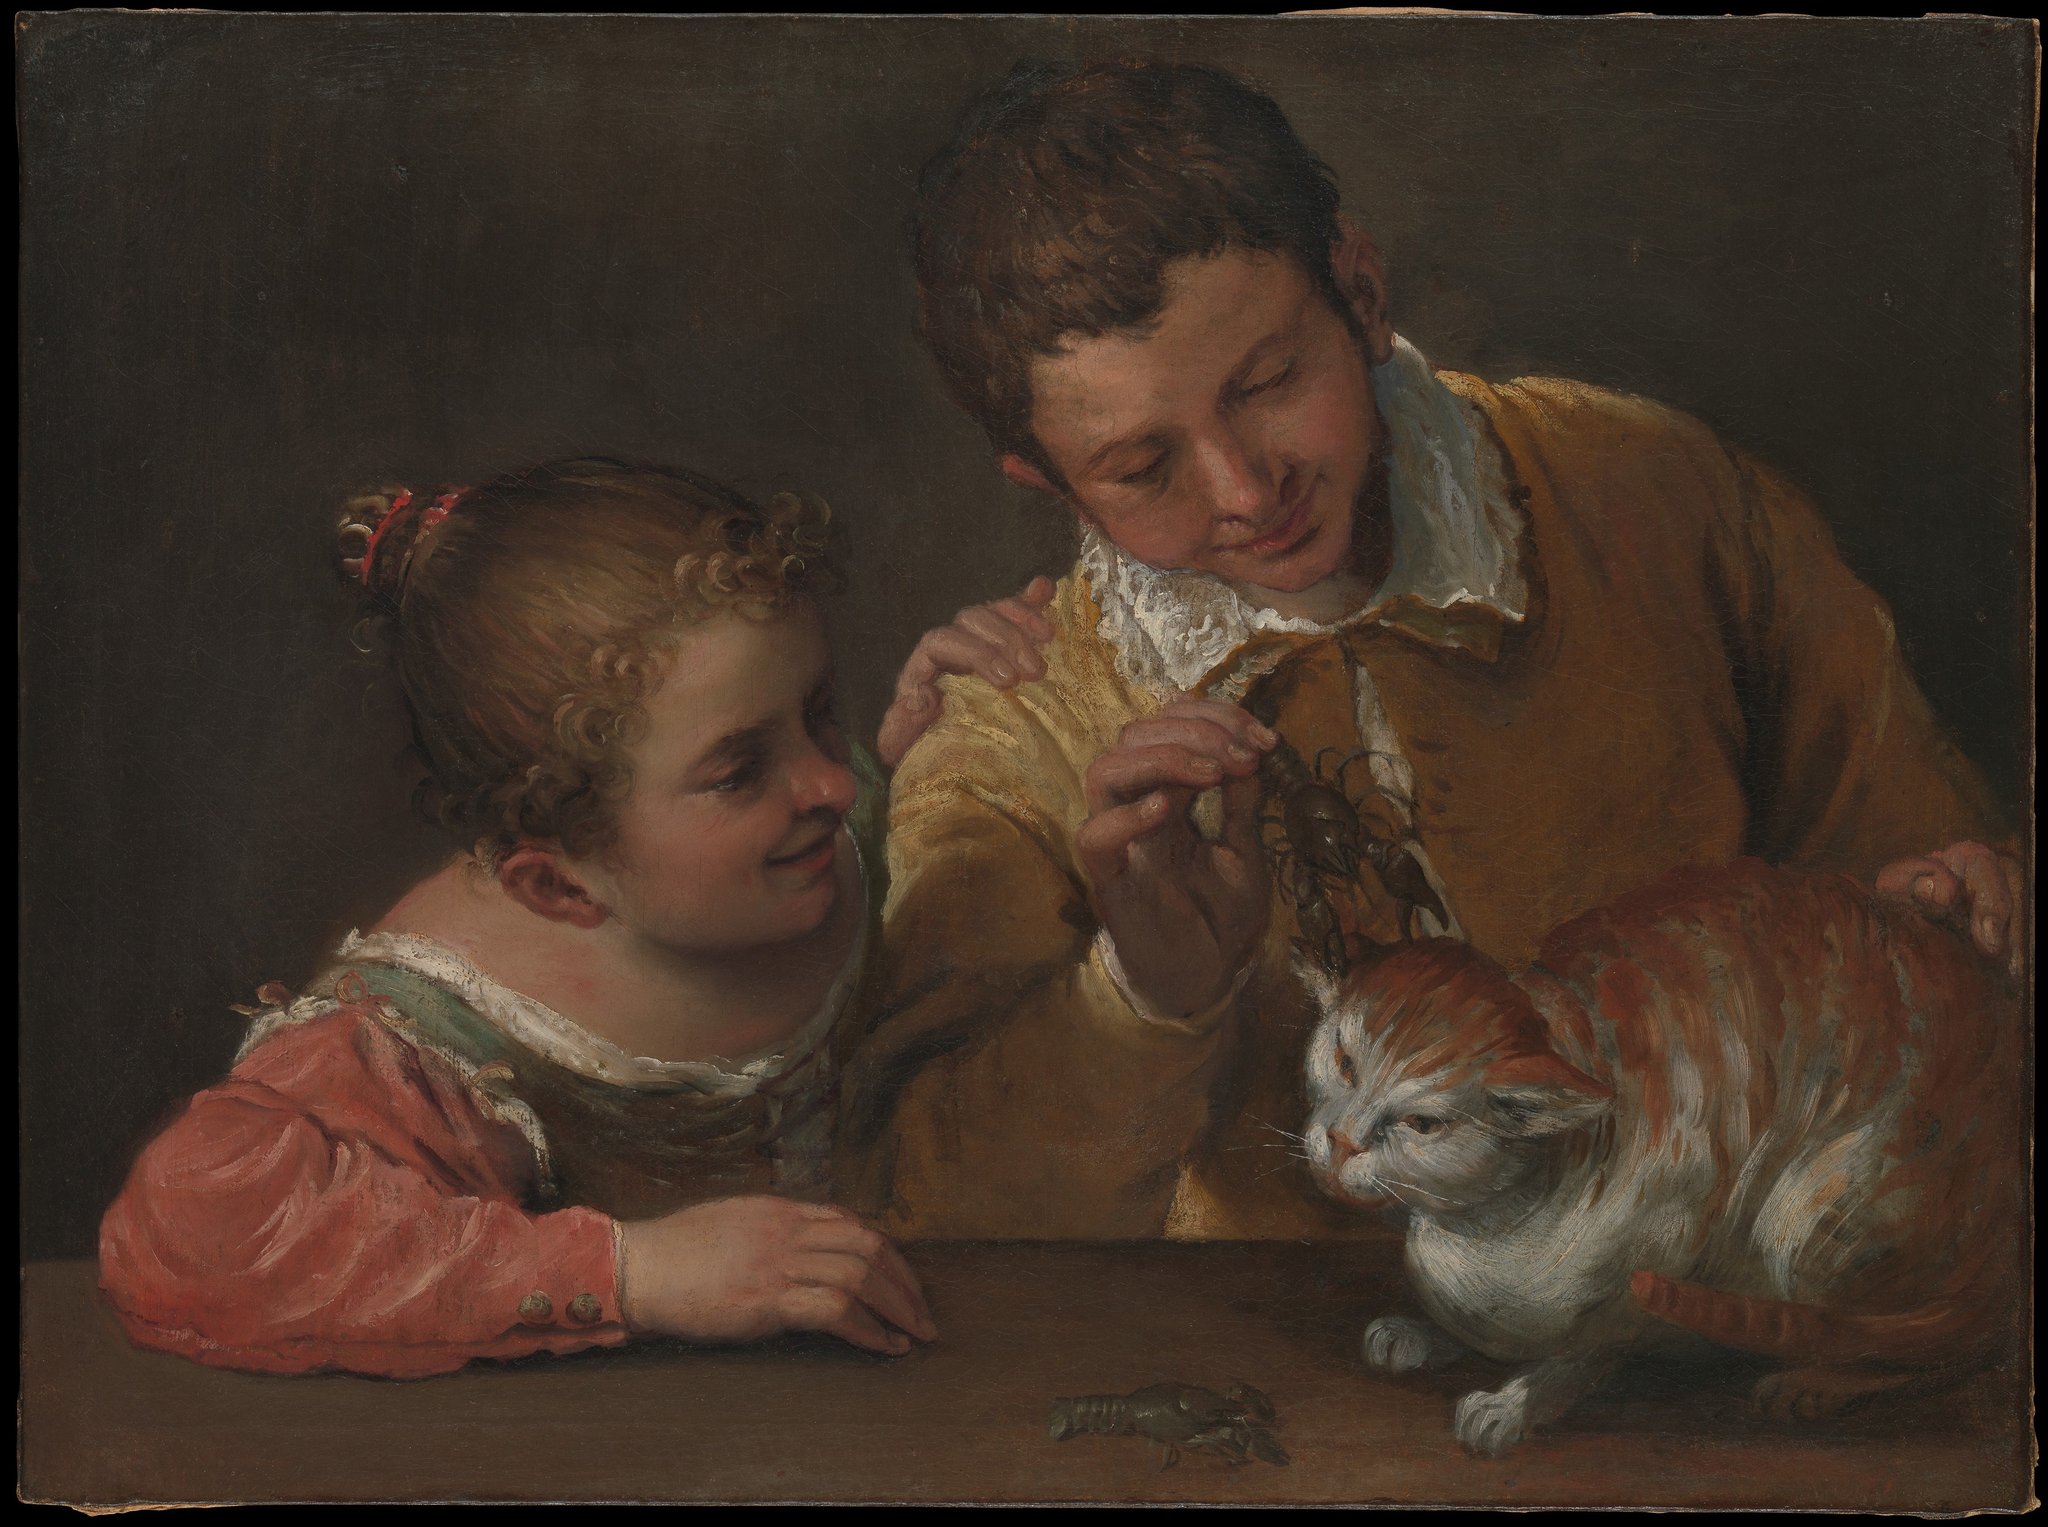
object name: painting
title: Two Children Teasing a Cat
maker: annibale carracci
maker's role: artist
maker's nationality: italian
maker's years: 1560-1609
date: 1587-1588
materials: canvas, oil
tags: boys,girls,cats,crayfish